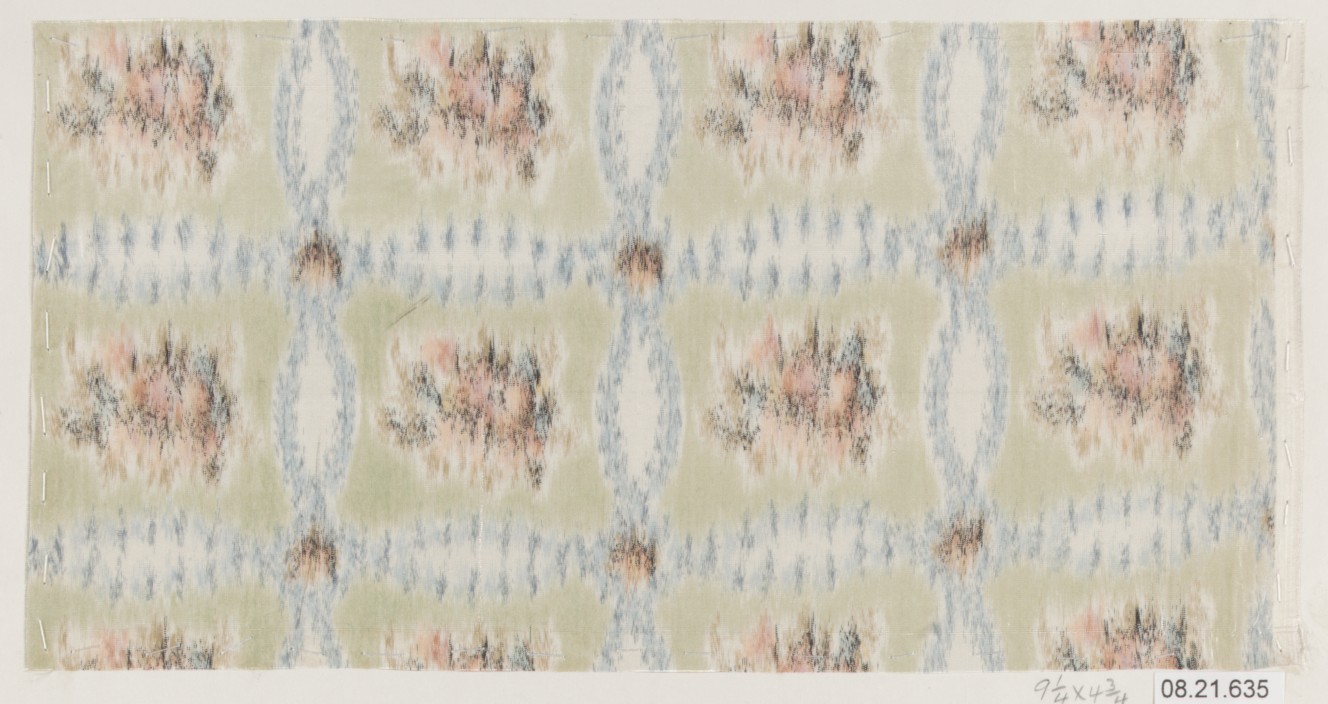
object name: textile sample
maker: Anonymous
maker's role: designer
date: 1900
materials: silk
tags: flowers